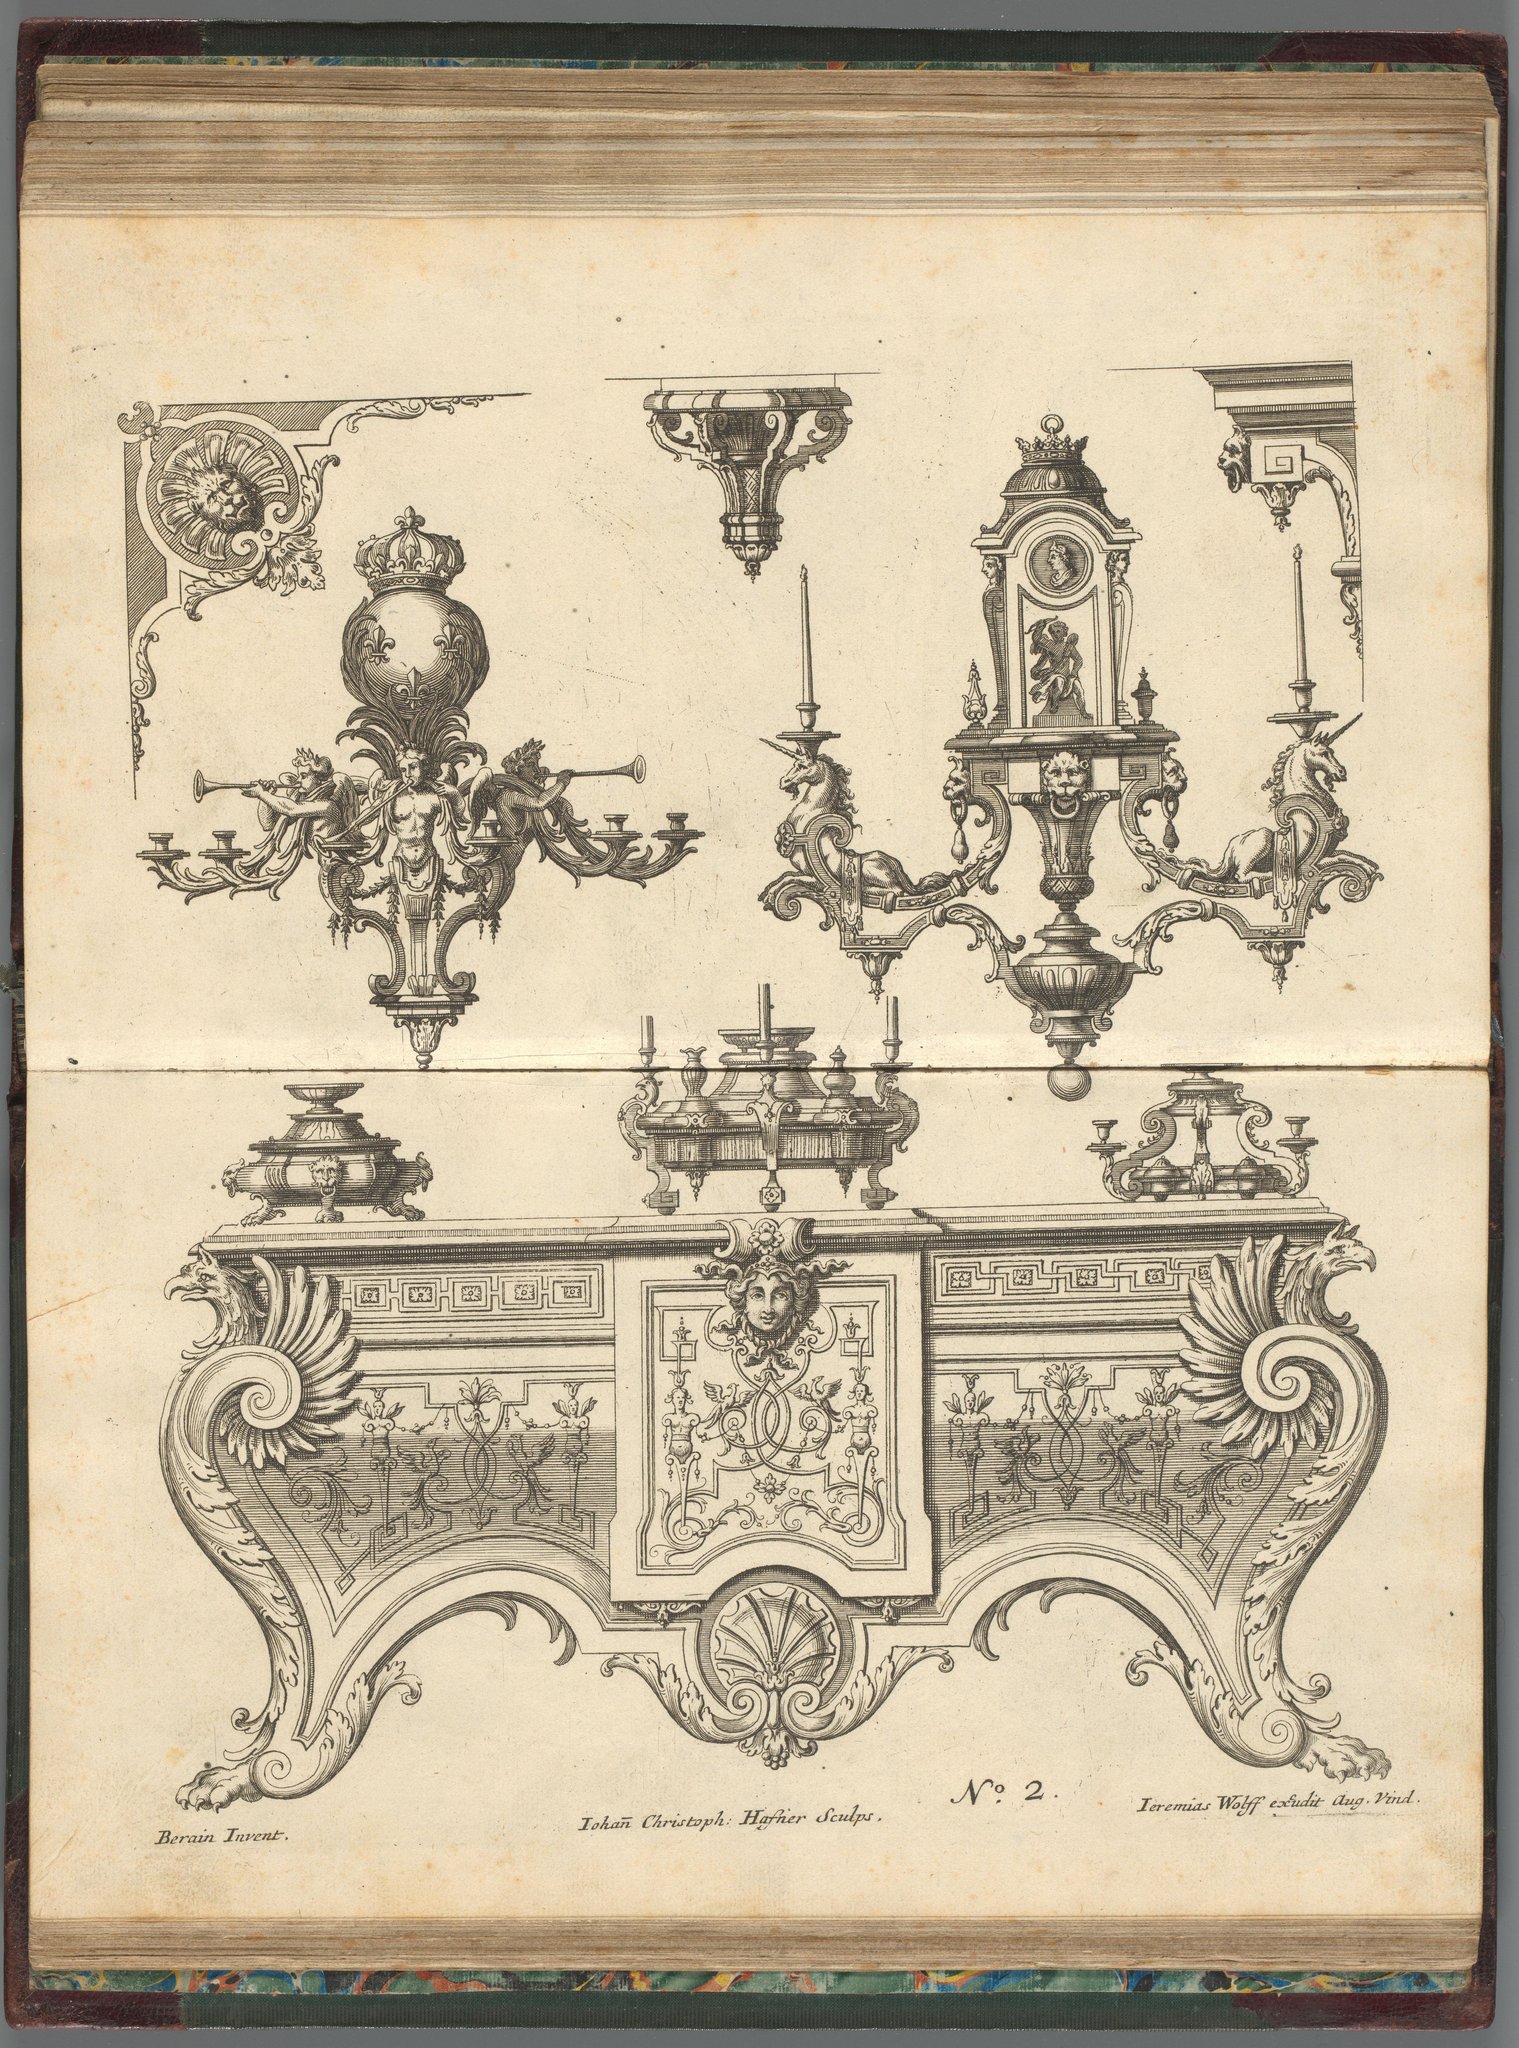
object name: print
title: Ontwerp van bureau met inlegwerk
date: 1686-1724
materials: paper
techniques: etching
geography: augsburg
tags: writing-table, writing-desk, ornaments ~ art, unicorn, candlestick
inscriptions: number: ‘No. 2.’, signature: ‘Ieremias Wolff excudit Aug. Vind.’, signature: ‘Berain Invent.’, signature: ‘Iohan Christoph Hafner Sculps.’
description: Ontwerp van een bureau met inlegwerk waarvan de zijkanten in de vorm van een console zijn versierd met een paneel. Het bureau rust op poten in de vorm van een klauw, die bekroond wordt met een adelaarskop. Op het bureau staan drie ontwerpen van serviesgoed. Boven het bureau zijn twee kandelaren; de linker met een bal met drie fleurs-de-lis en gekroond met de Franse kroon en de rechter versierd met eenhoorns. Bovenaan twee consoles en een ornamenteel motief met een masker van een leeuwskop. Prent maakt deel uit van een album. Hoogstwaarschijnlijk gespiegelde kopie naar Frans origineel.